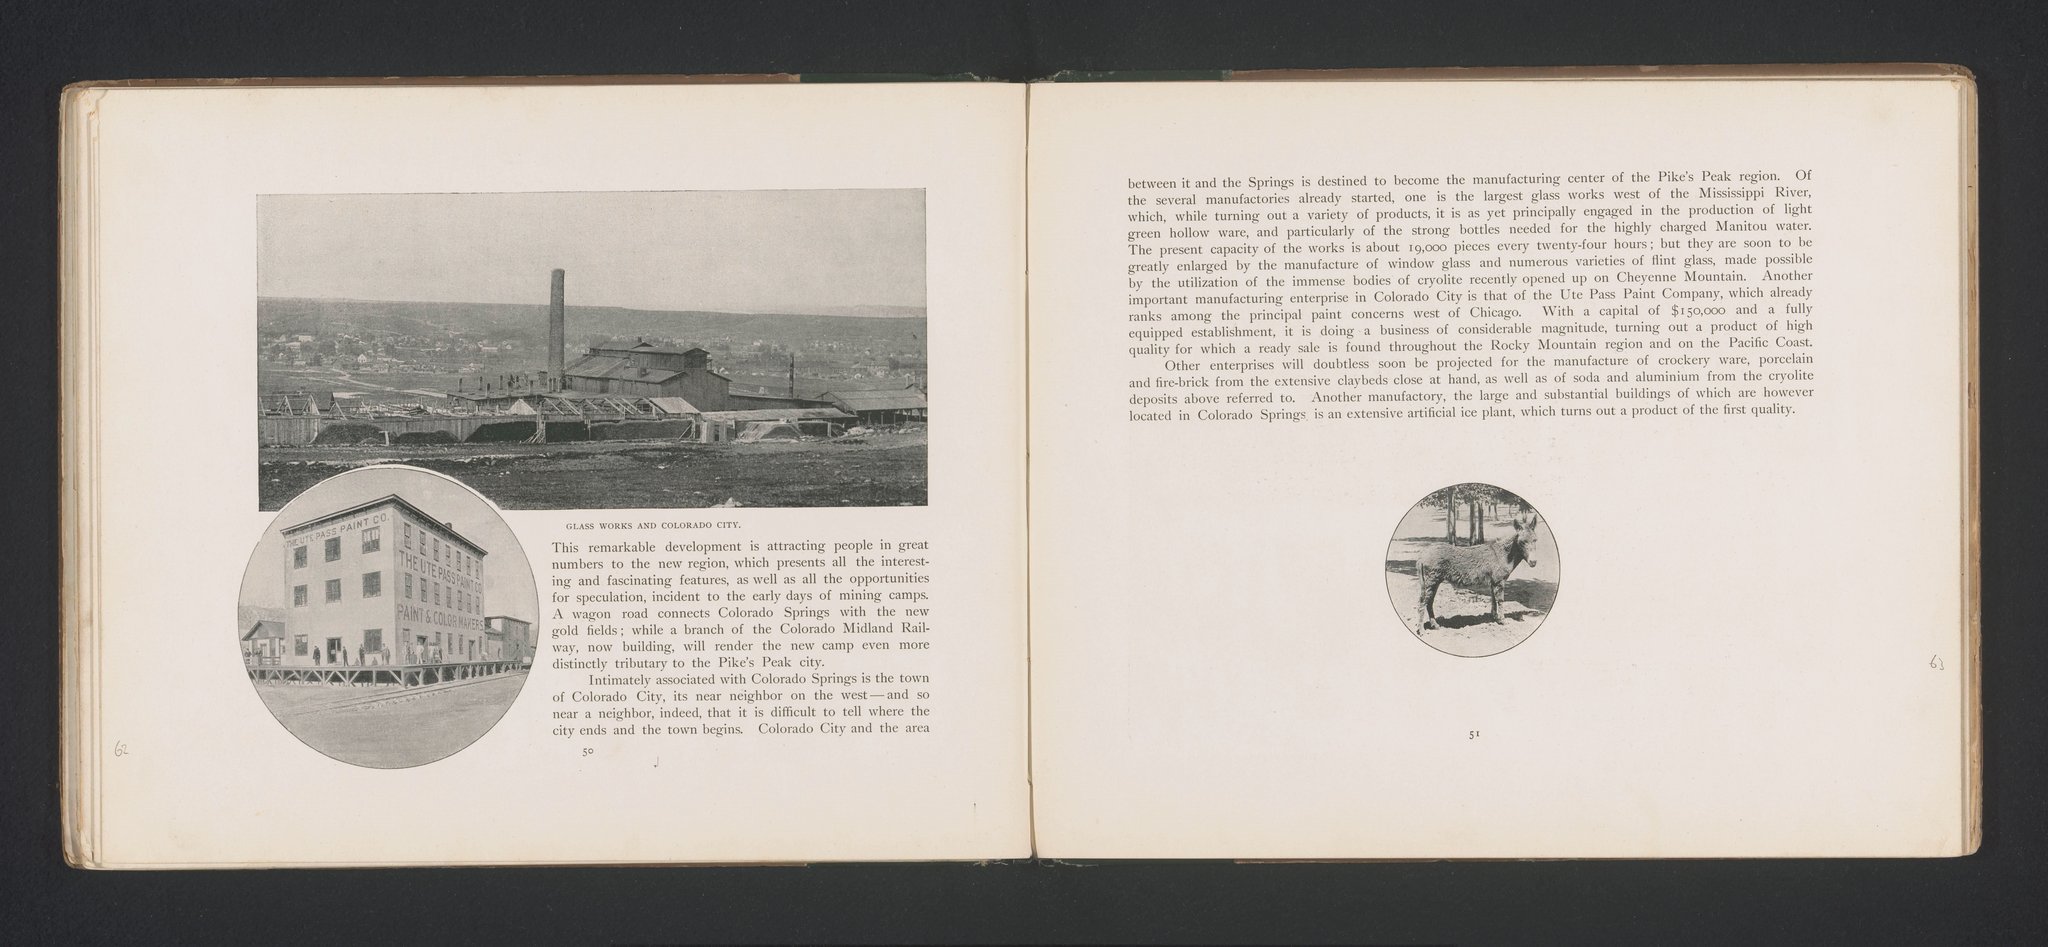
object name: photomechanical print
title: Ezel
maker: Anonymous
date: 1888-1893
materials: paper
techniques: autotype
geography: colorado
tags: ass, donkey